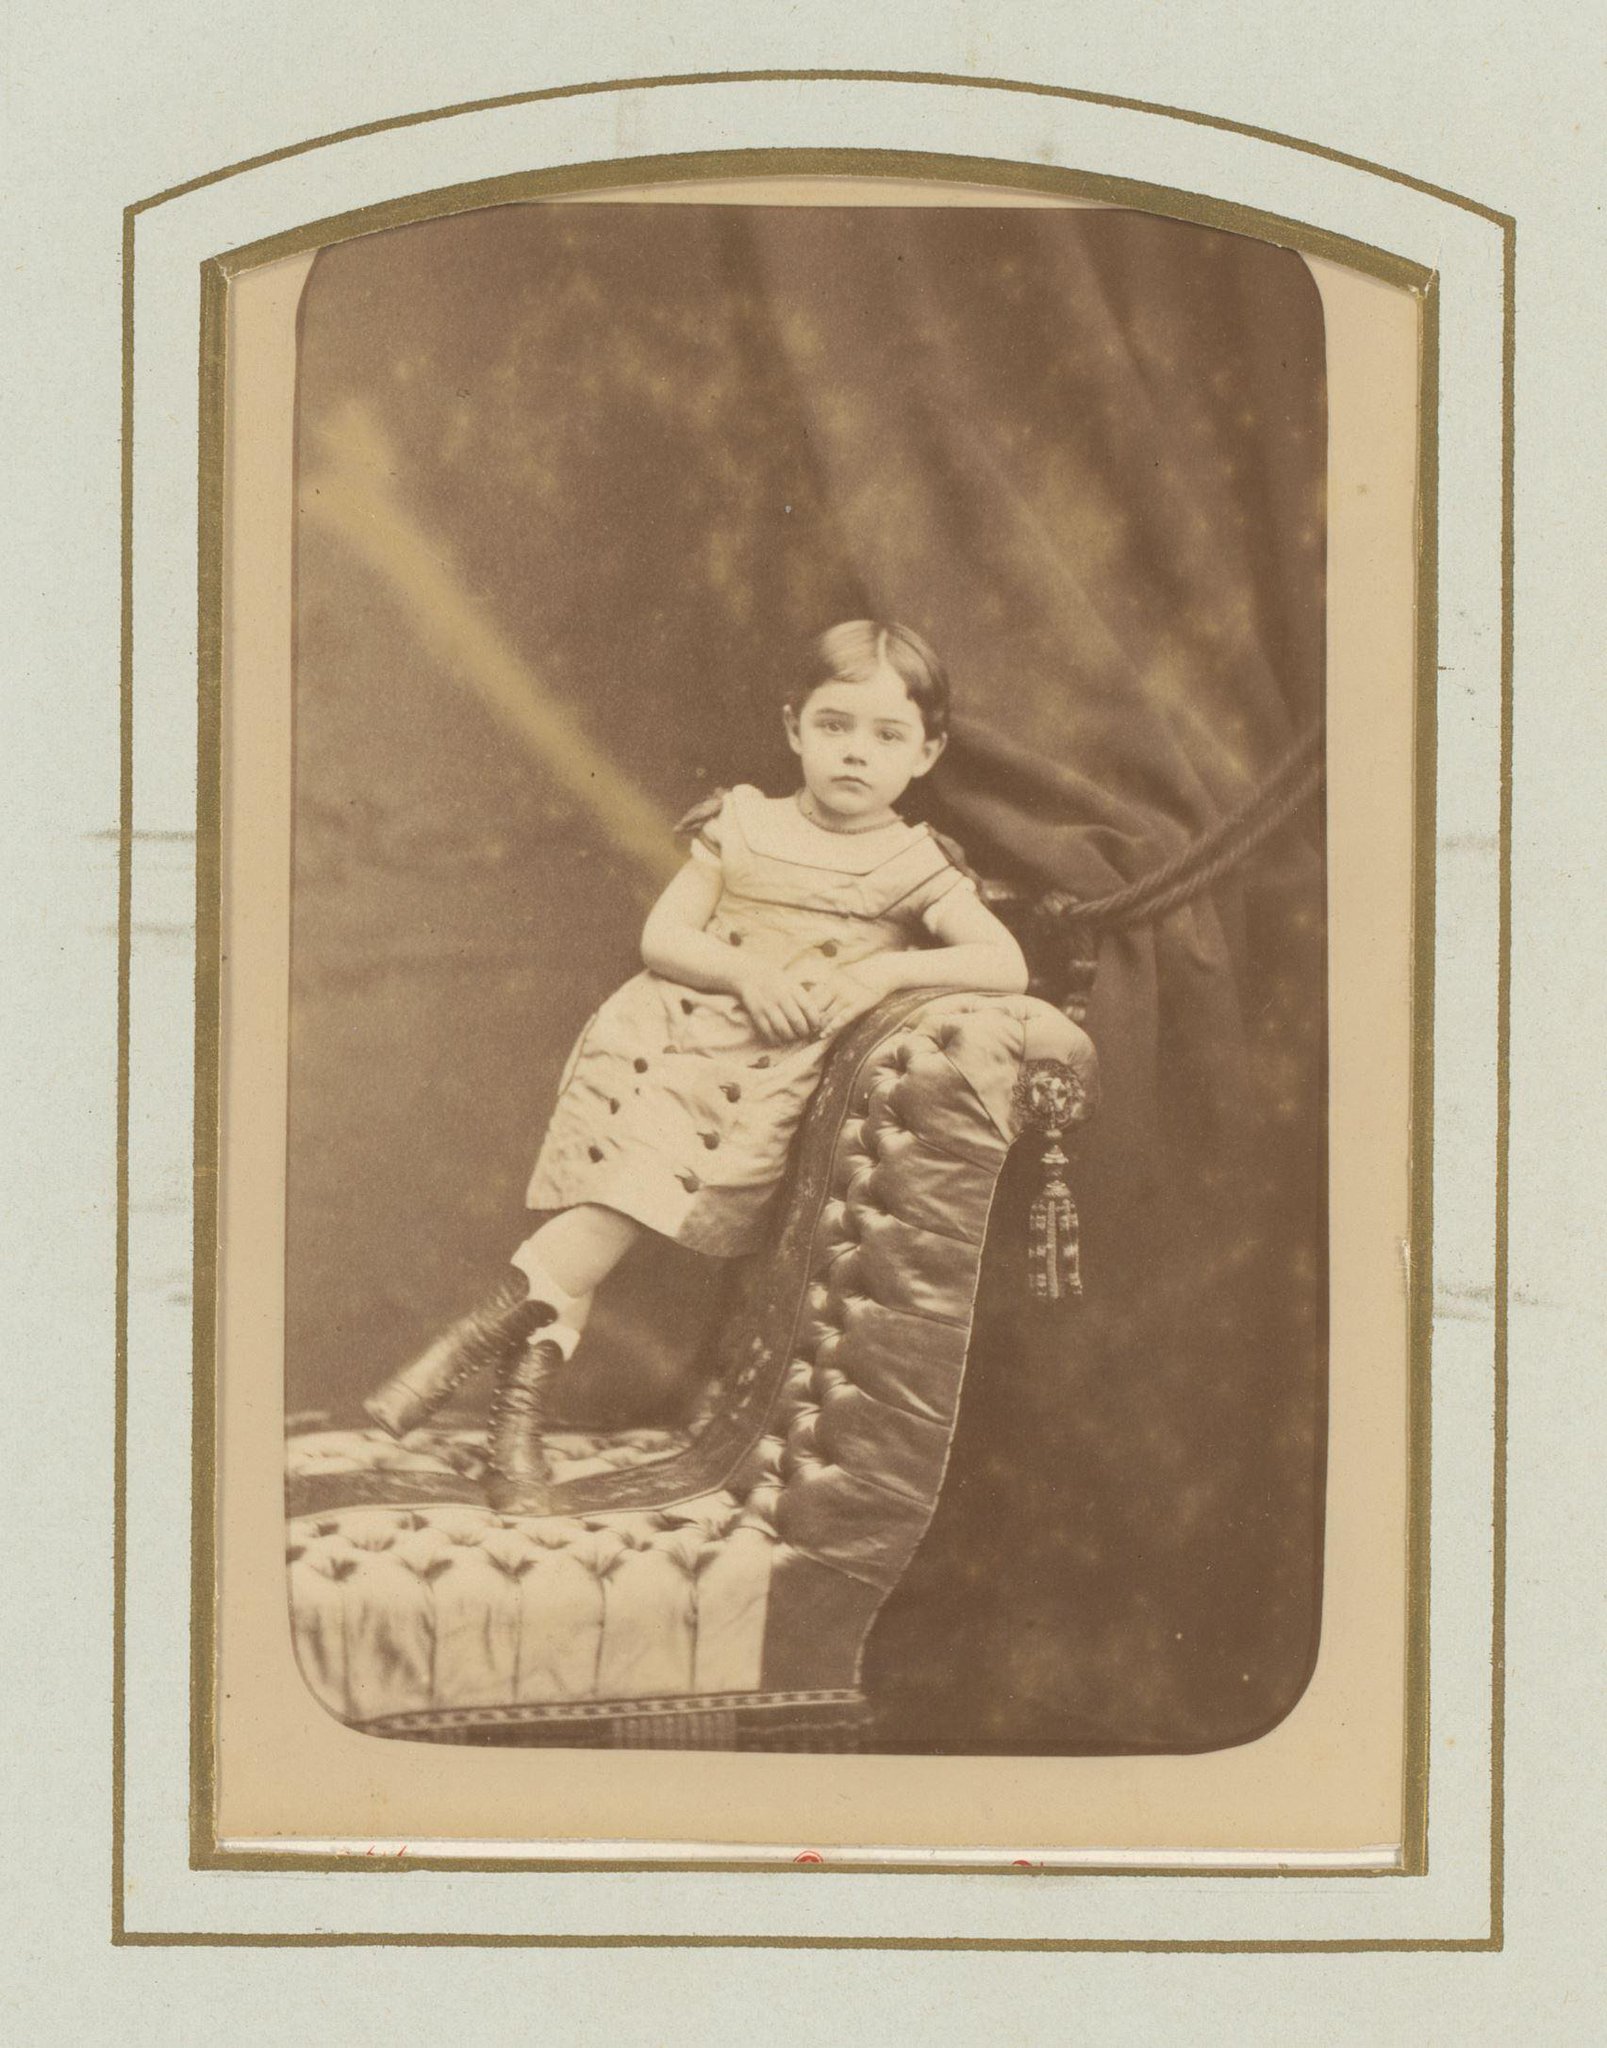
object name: photograph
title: Portret van een meisje, staand op een sofa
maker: angelo maria alessio caccia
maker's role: fotograaf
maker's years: 1802-1877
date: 1850-1900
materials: cardboard, photographic support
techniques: albumen print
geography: le havre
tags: historical persons - bb - woman, girl (child between toddler and youth), couch, sofa, settee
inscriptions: inscription: ‘Portrait - Album/ A. CACCIA, Phot. - 126, Bould. de Strasbourg/ HÂVRE’